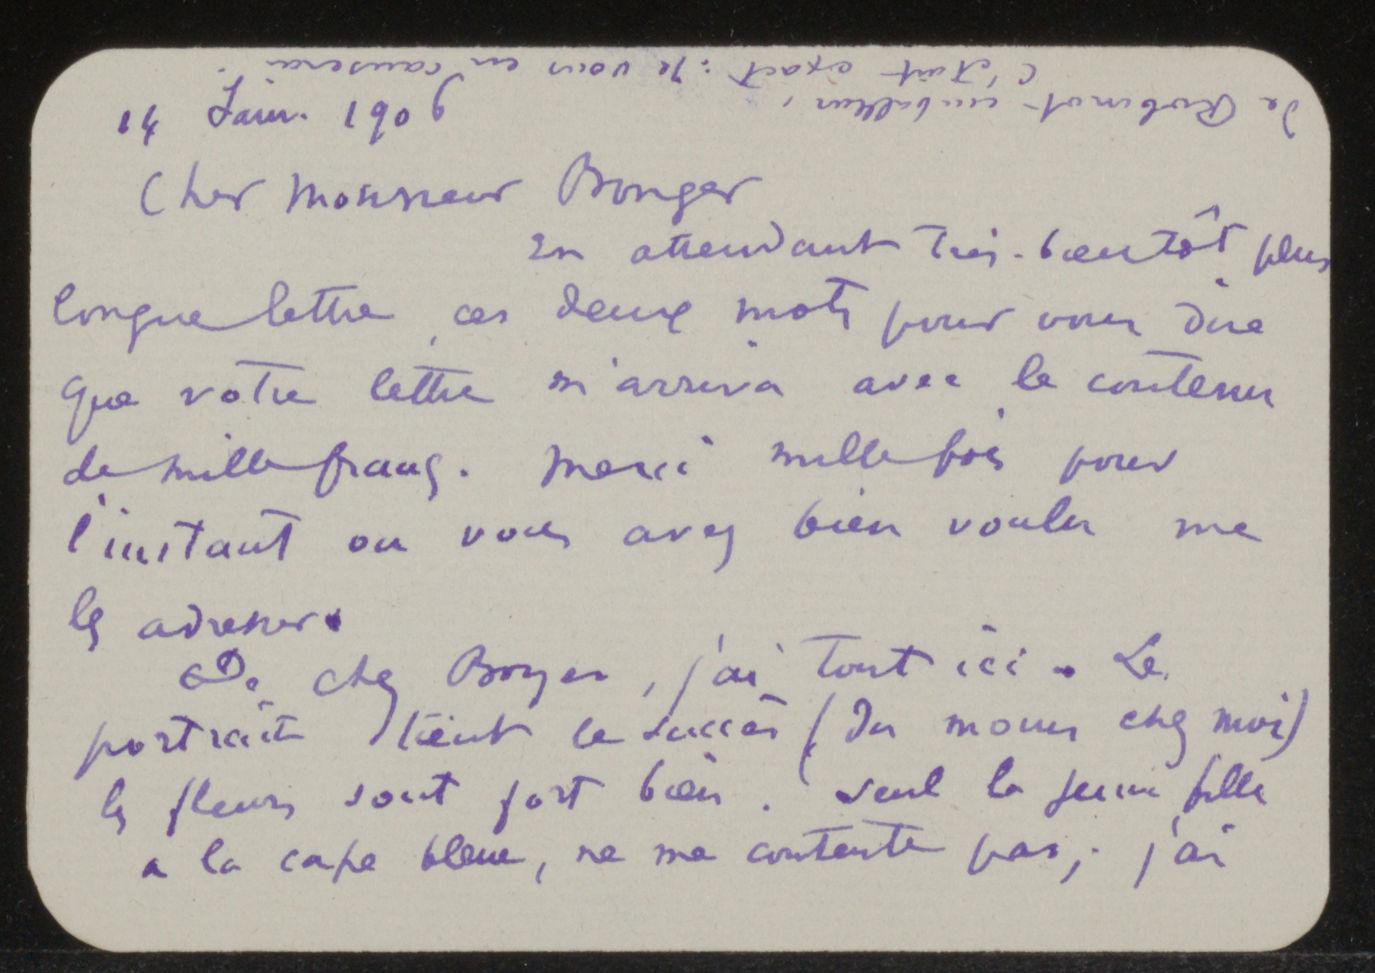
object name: letter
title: Brief aan Andries Bonger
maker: odilon redon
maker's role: draughtsman, painter, print maker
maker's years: 1840-1916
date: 1906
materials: ink, paper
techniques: pen, writing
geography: paris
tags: amsterdam, andries bonger, zwickau, robert schumann, willem jan gerrit van meurs, drawing, music, photography, cinematography, historical persons (portraits and scenes from the life), money